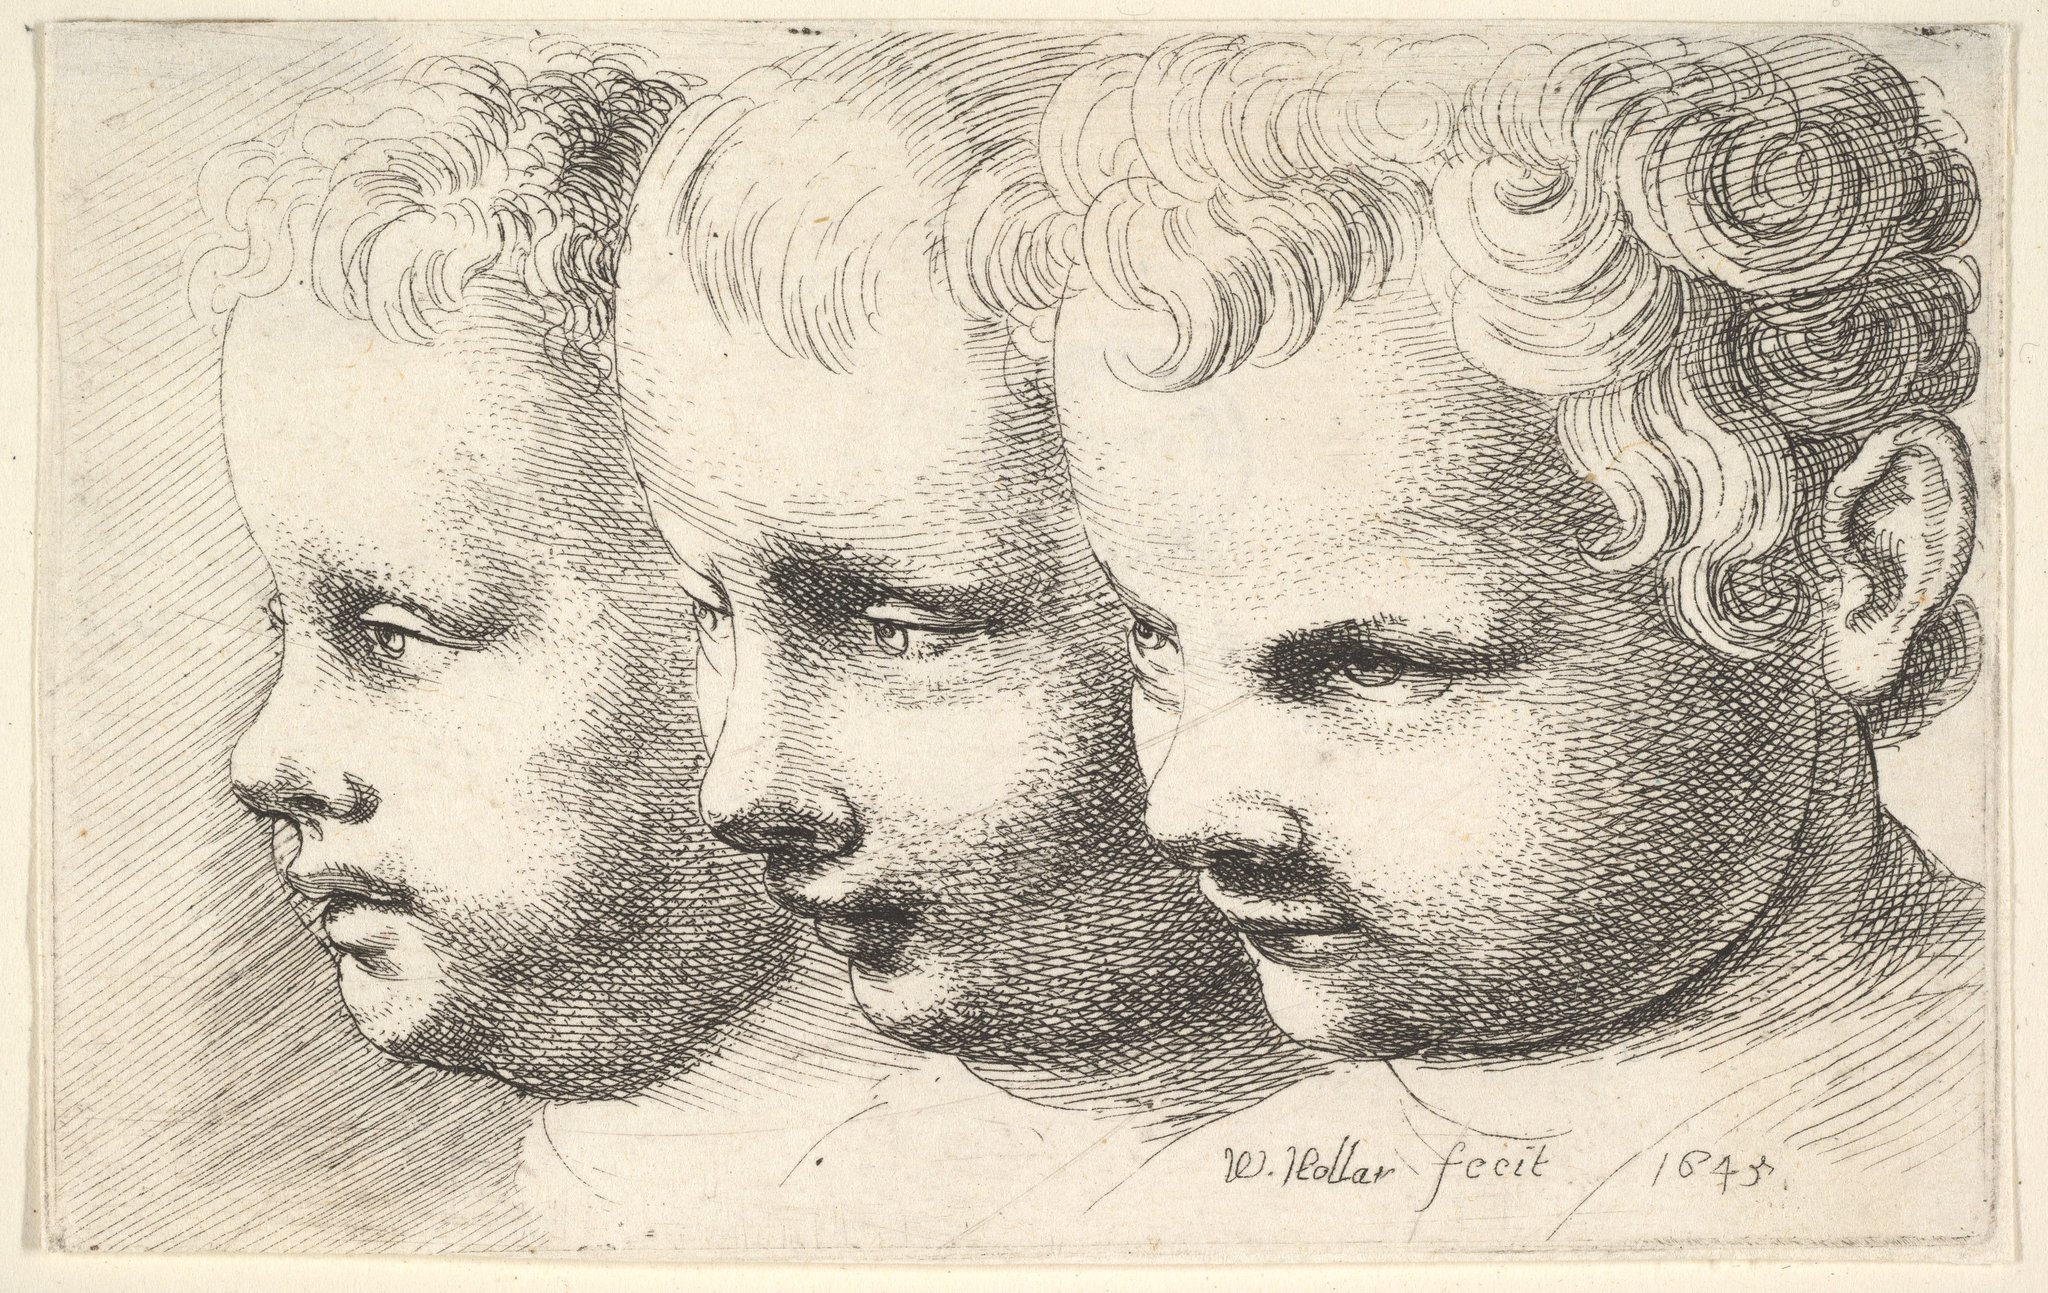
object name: print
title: Three children's heads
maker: wenceslaus hollar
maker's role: artist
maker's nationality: bohemian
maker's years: 1607-1677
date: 1645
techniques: etching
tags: heads,children